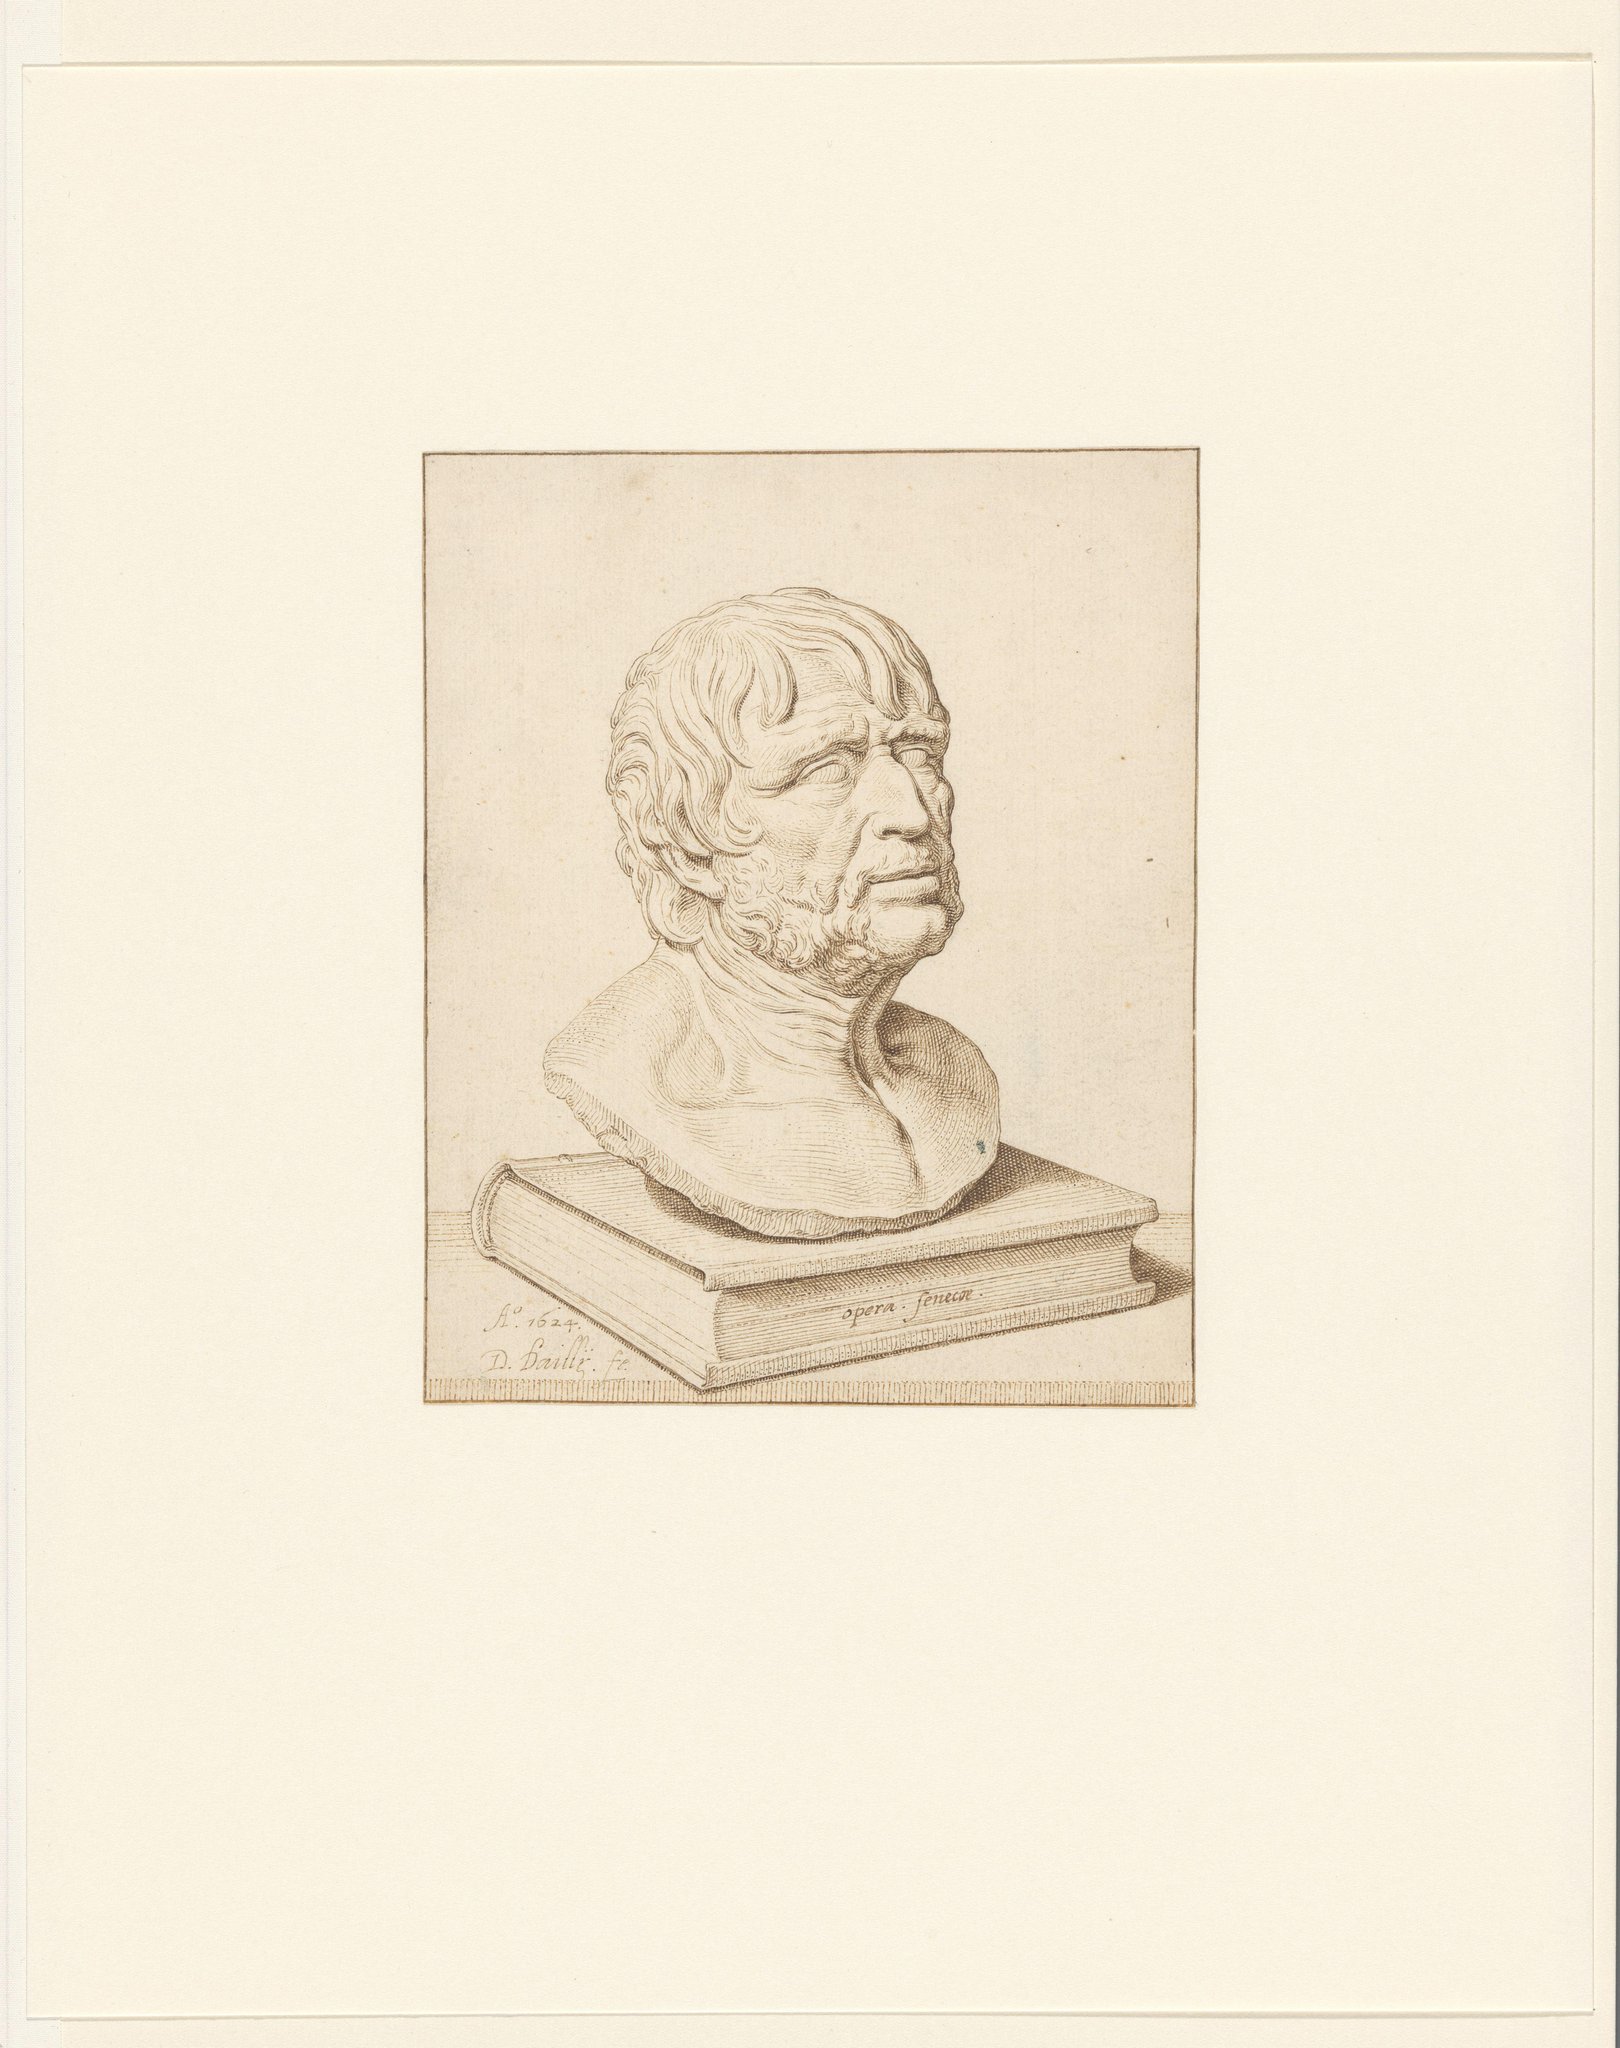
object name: drawing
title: Portrait bust of Seneca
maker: david bailly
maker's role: draughtsman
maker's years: 1584-1657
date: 1624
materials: ink, paper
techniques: pen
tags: lucius annaeus seneca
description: Borstbeeld van Seneca, naar rechts gewend, staande op een boek.